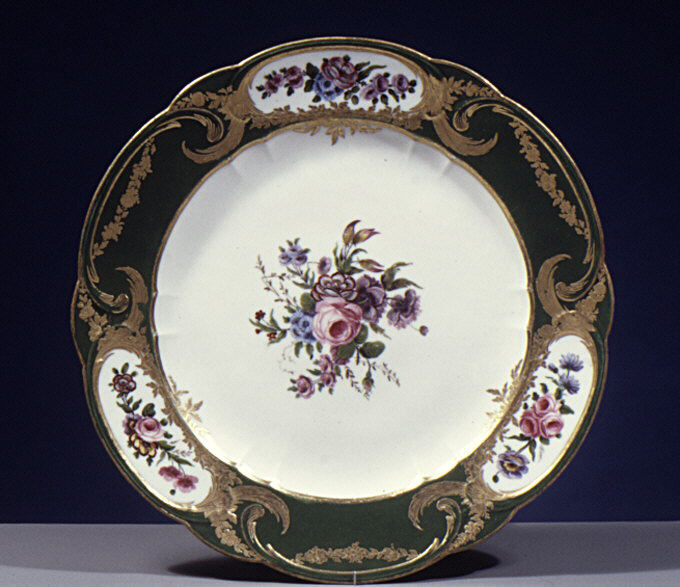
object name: plate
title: Plate (assiette à palmes) (1 of 102) (part of a service)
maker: sèvres manufactory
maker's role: manufactory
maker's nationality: french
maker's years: 1740-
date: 1768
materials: soft paste porcelain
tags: flowers